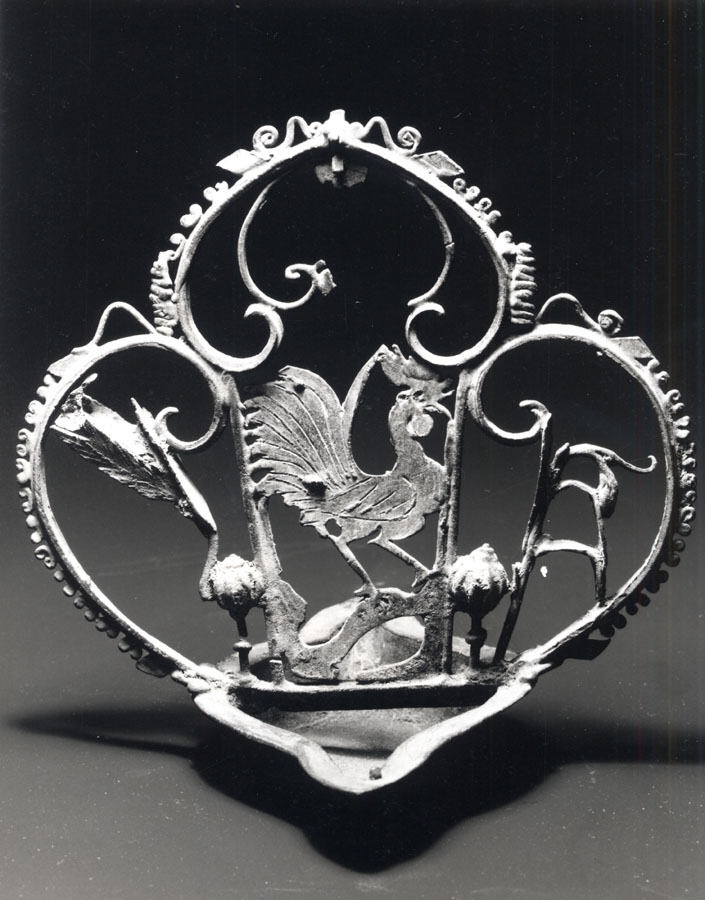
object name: oil lamp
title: Oil Lamp with Cock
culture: indonesian, javanese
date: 801-1000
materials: bronze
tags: roosters